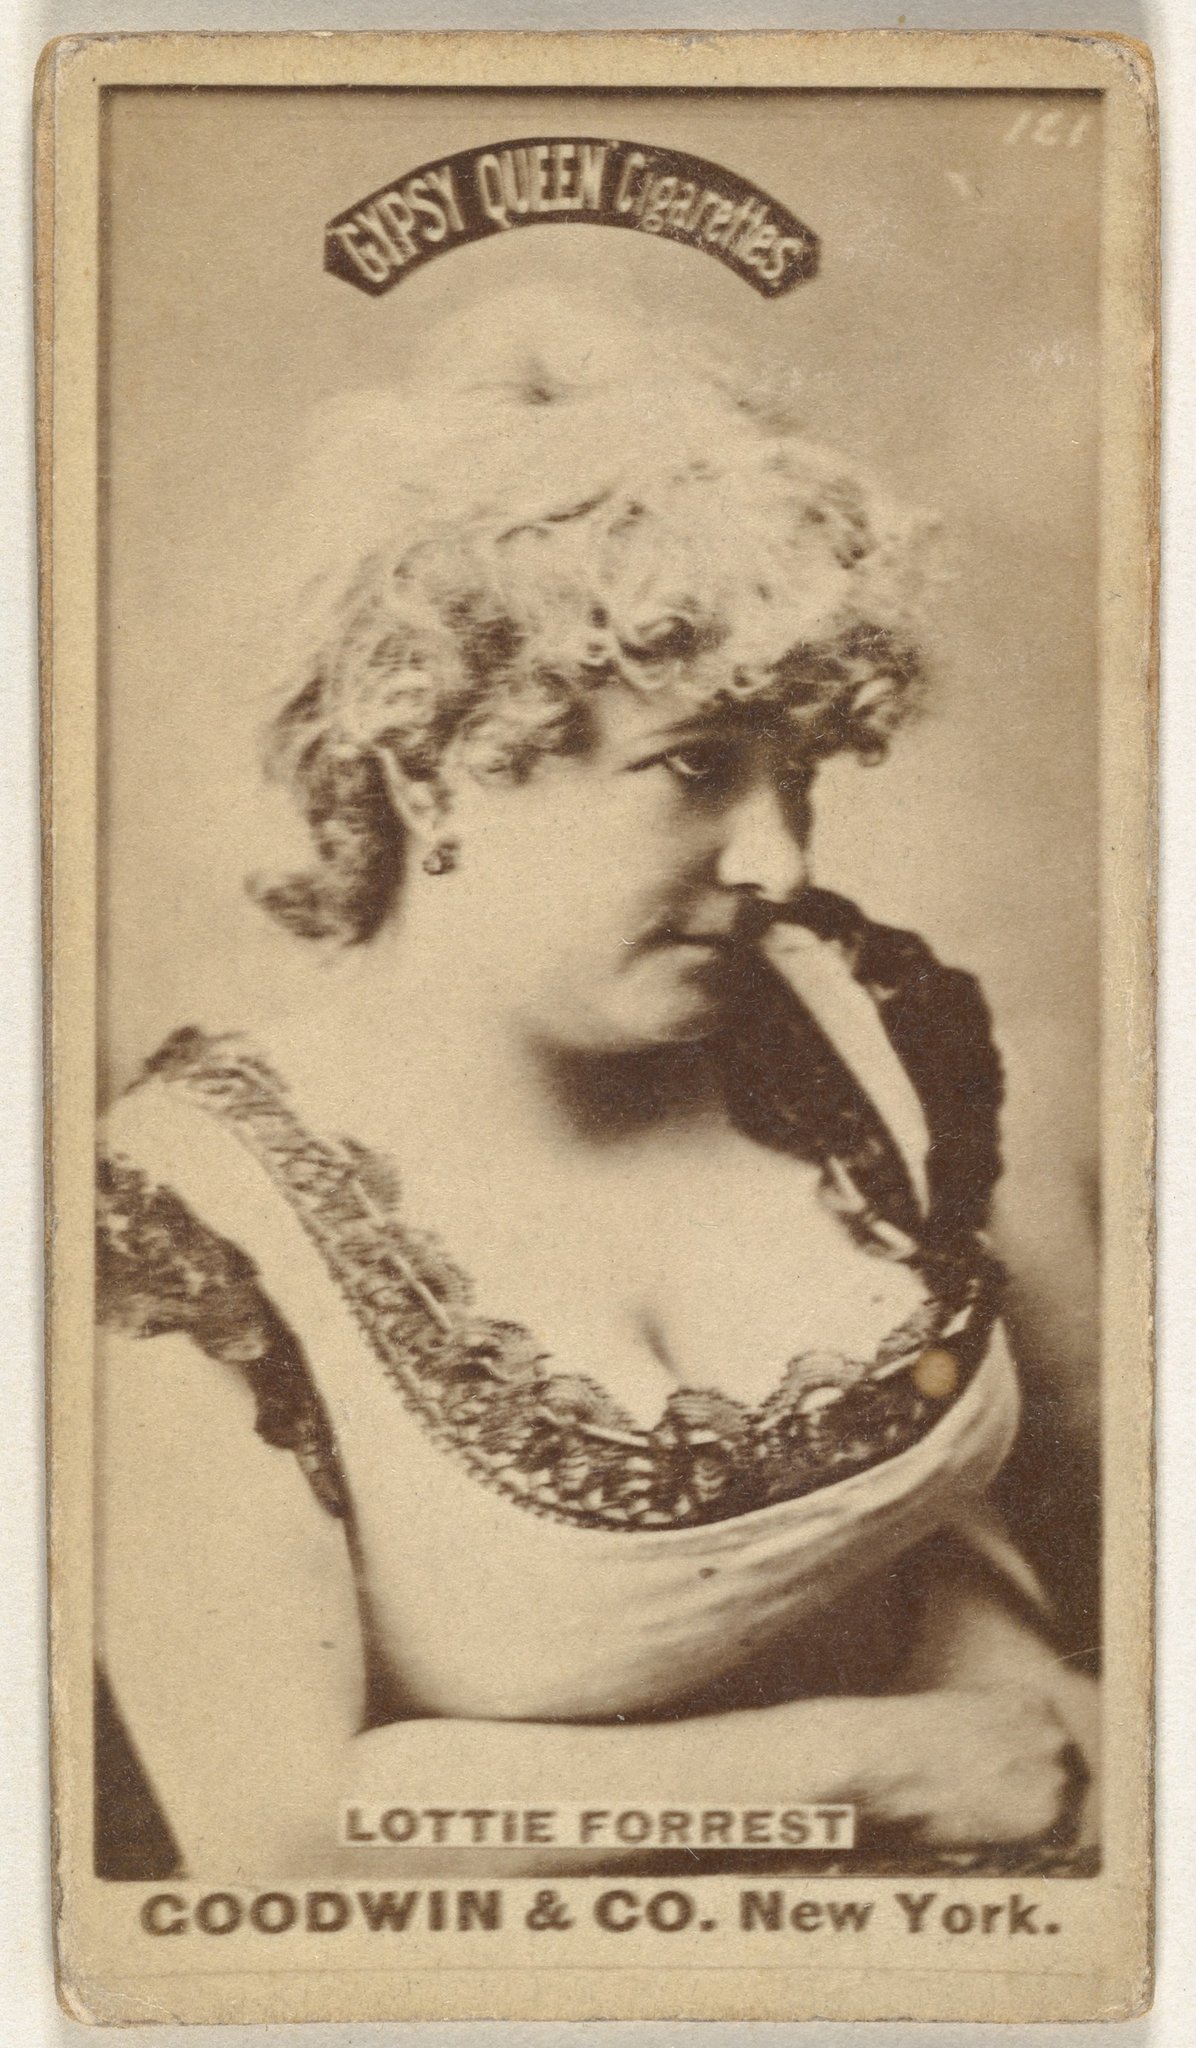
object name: photograph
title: Lottie Forrest, from the Actors and Actresses series (N171) for Gypsy Queen Cigarettes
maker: goodwin & company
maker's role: publisher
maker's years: 1850-1950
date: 1886-1890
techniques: albumen silver print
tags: portraits,women,actresses